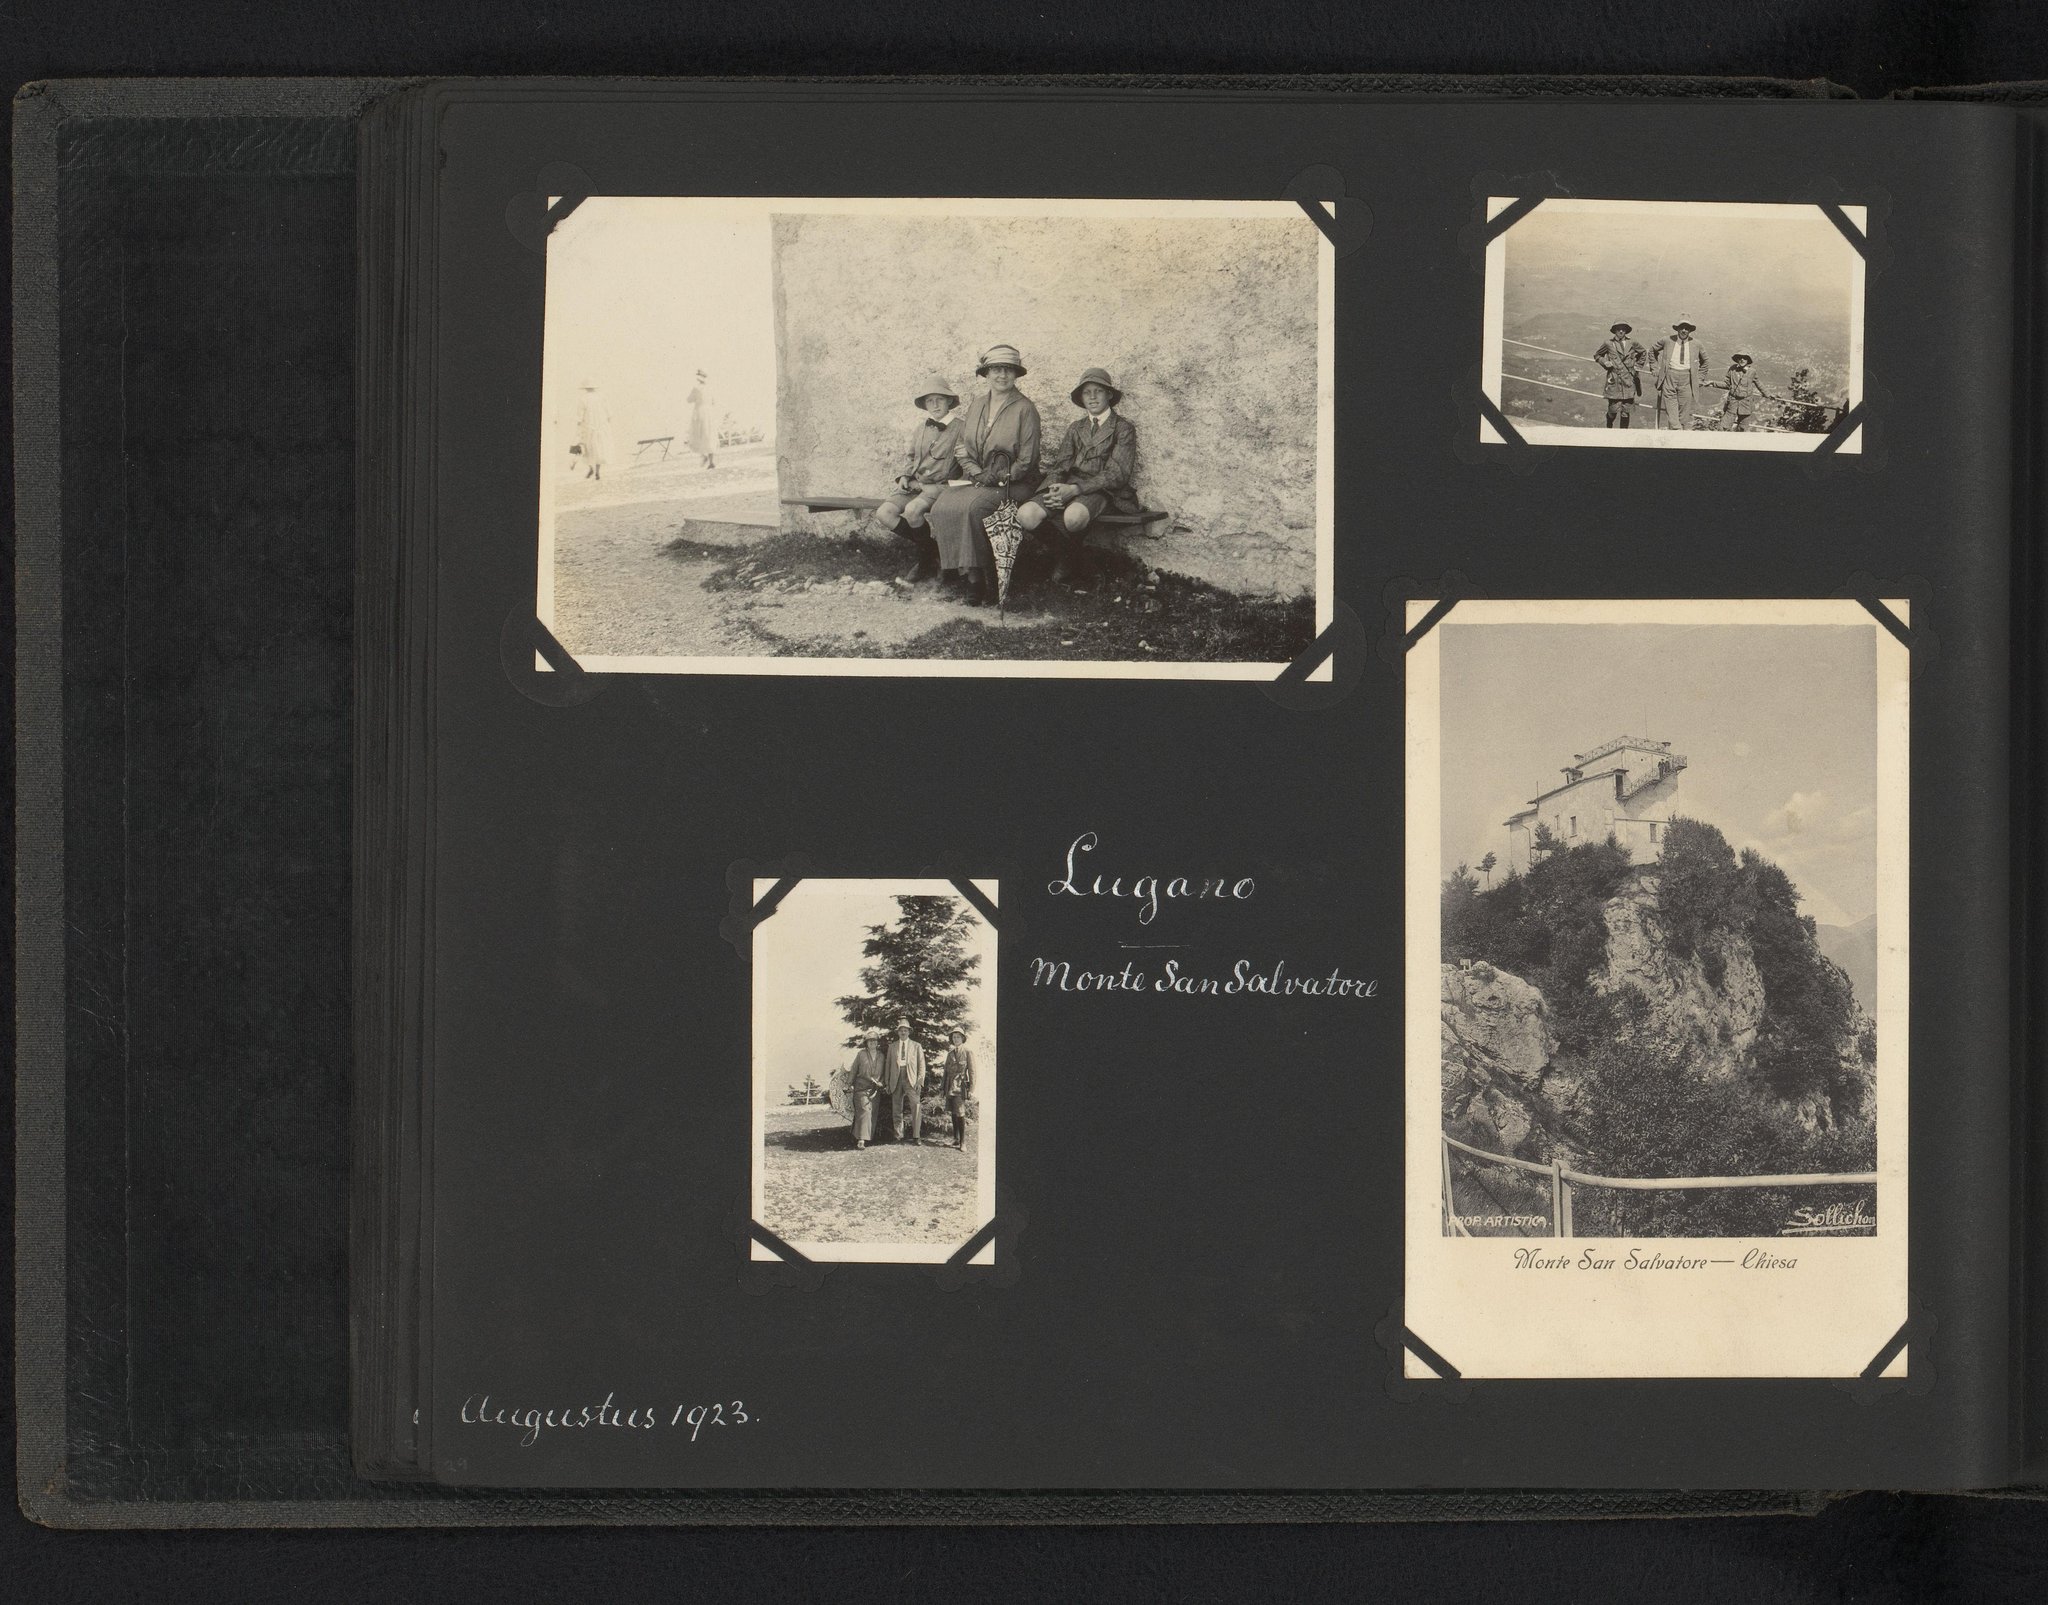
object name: photomechanical print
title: Drie foto's van de familie Van den Berg op de Monte San Salvatore en een fotomechanische prentbriefkaart daarvan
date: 1908-1923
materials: paper, cardboard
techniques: photograph, gelatin silver print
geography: lugano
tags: batavia, hendrik herman van den berg, the hague, caroline louise van den berg-van den berg, carel frederik van den berg (cay), amsterdam, frank willem van den berg (1912-1998), the family travelling, on holiday, (high) hill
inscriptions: inscription: ‘Lugano/ Monte San Salvatore’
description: Deze foto's en prent maken deel uit van een album.